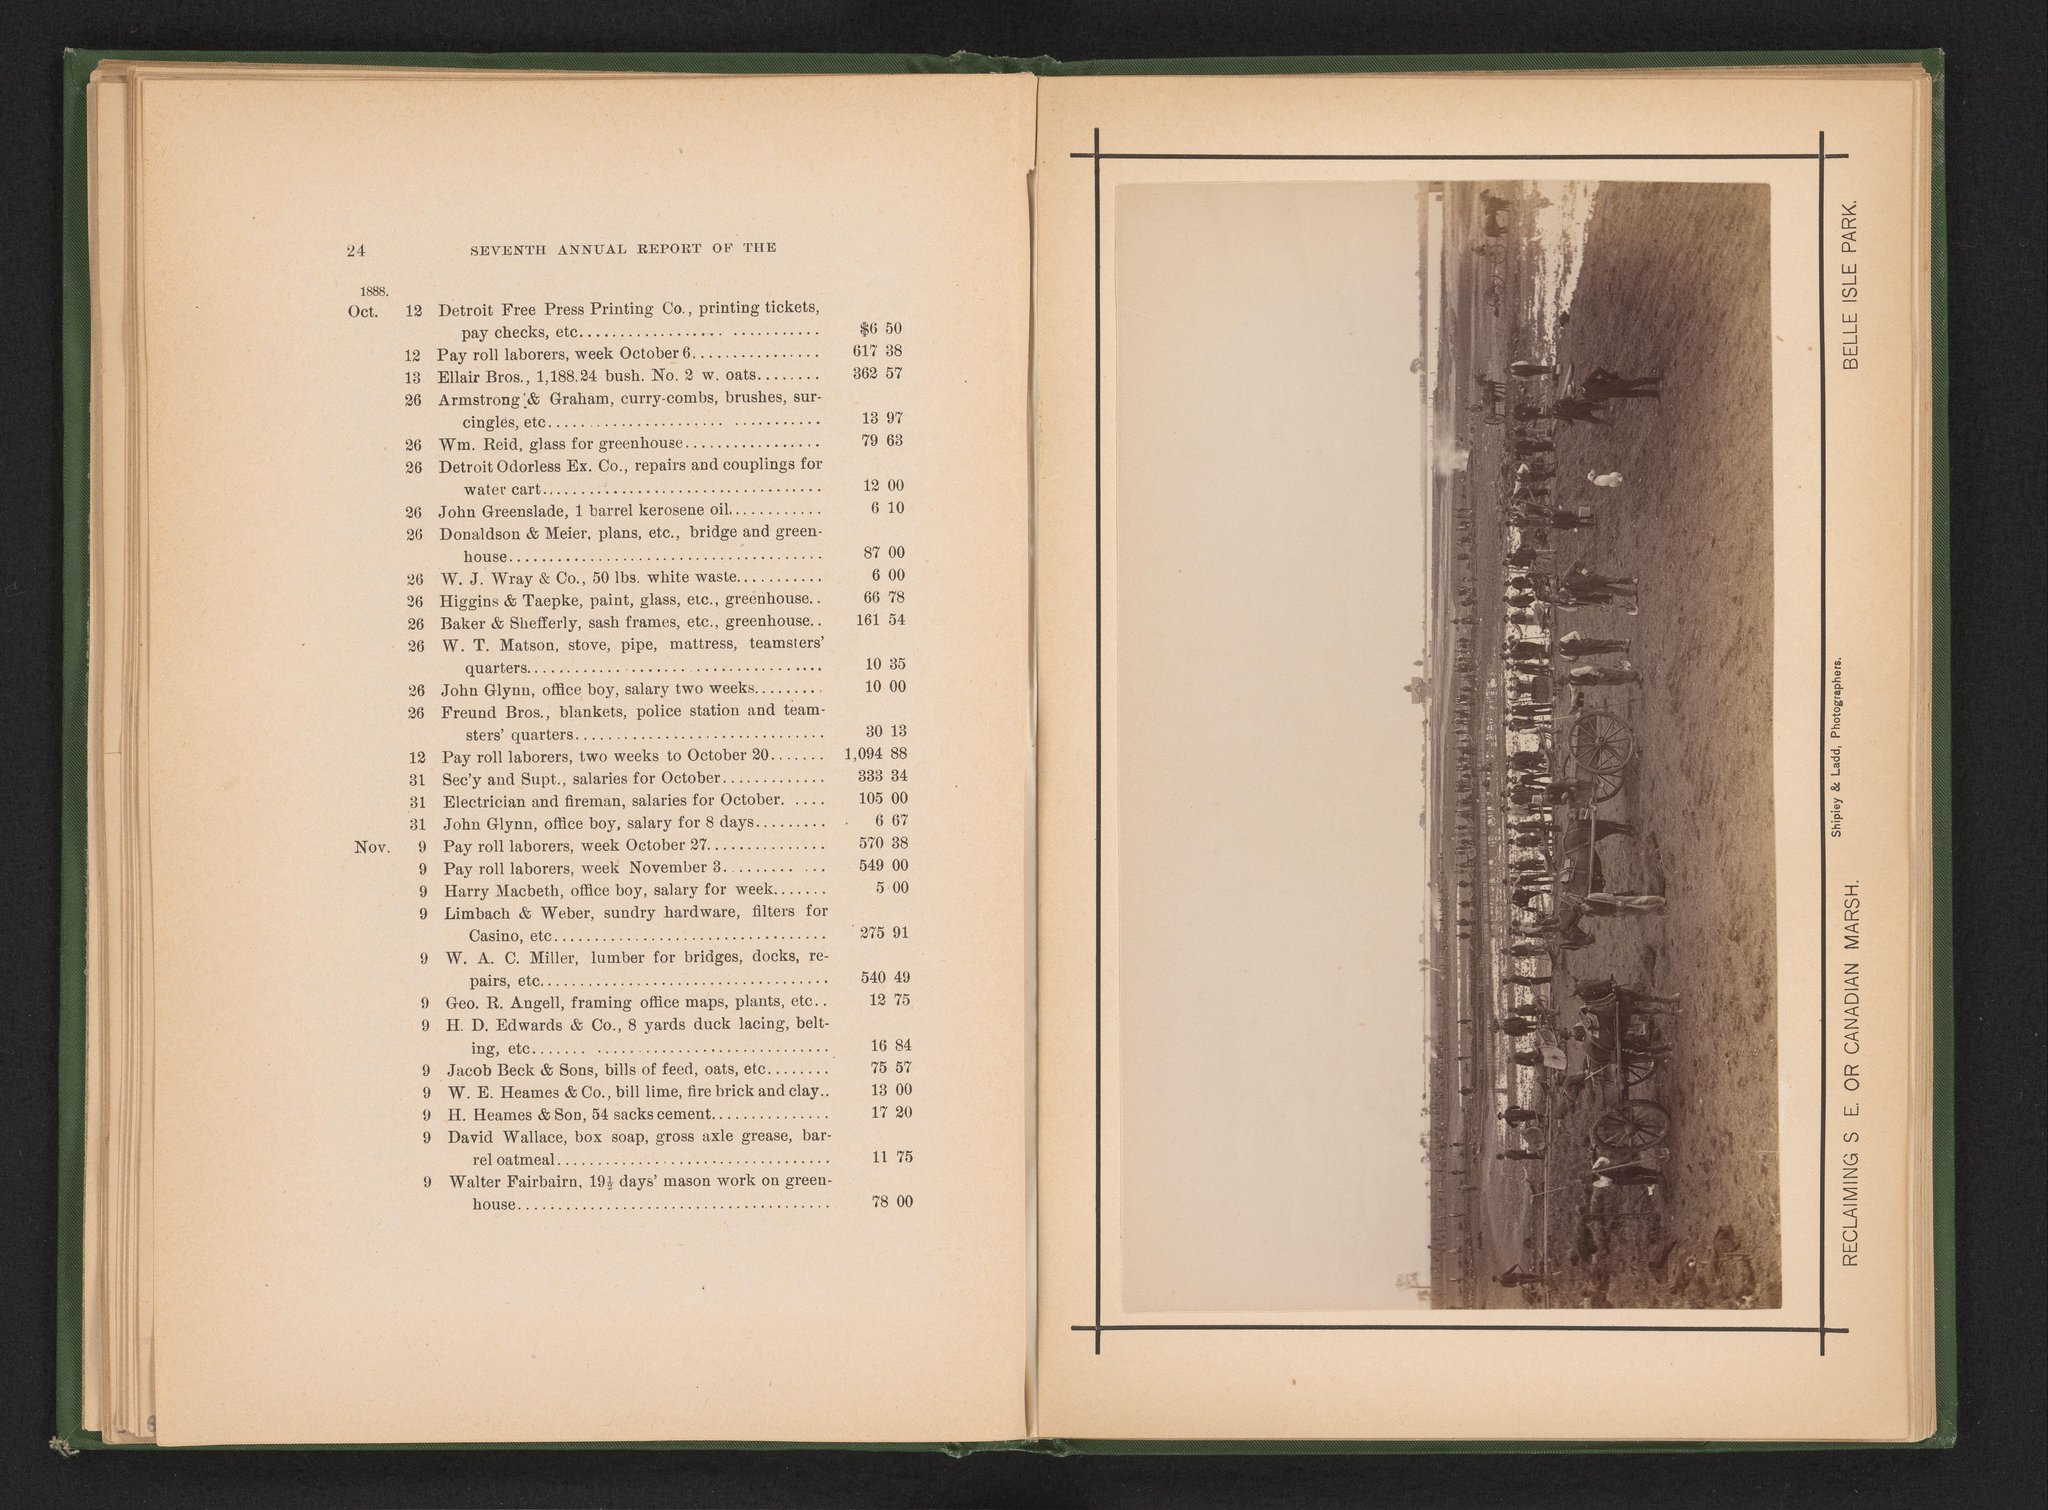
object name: photograph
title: Gezicht op de werkzaamheden om een moeras droog te leggen op het Belle Isle Park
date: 1879-1889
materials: photographic support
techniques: albumen print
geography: belle isle park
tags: coastal marsh, polder, reclaimed land